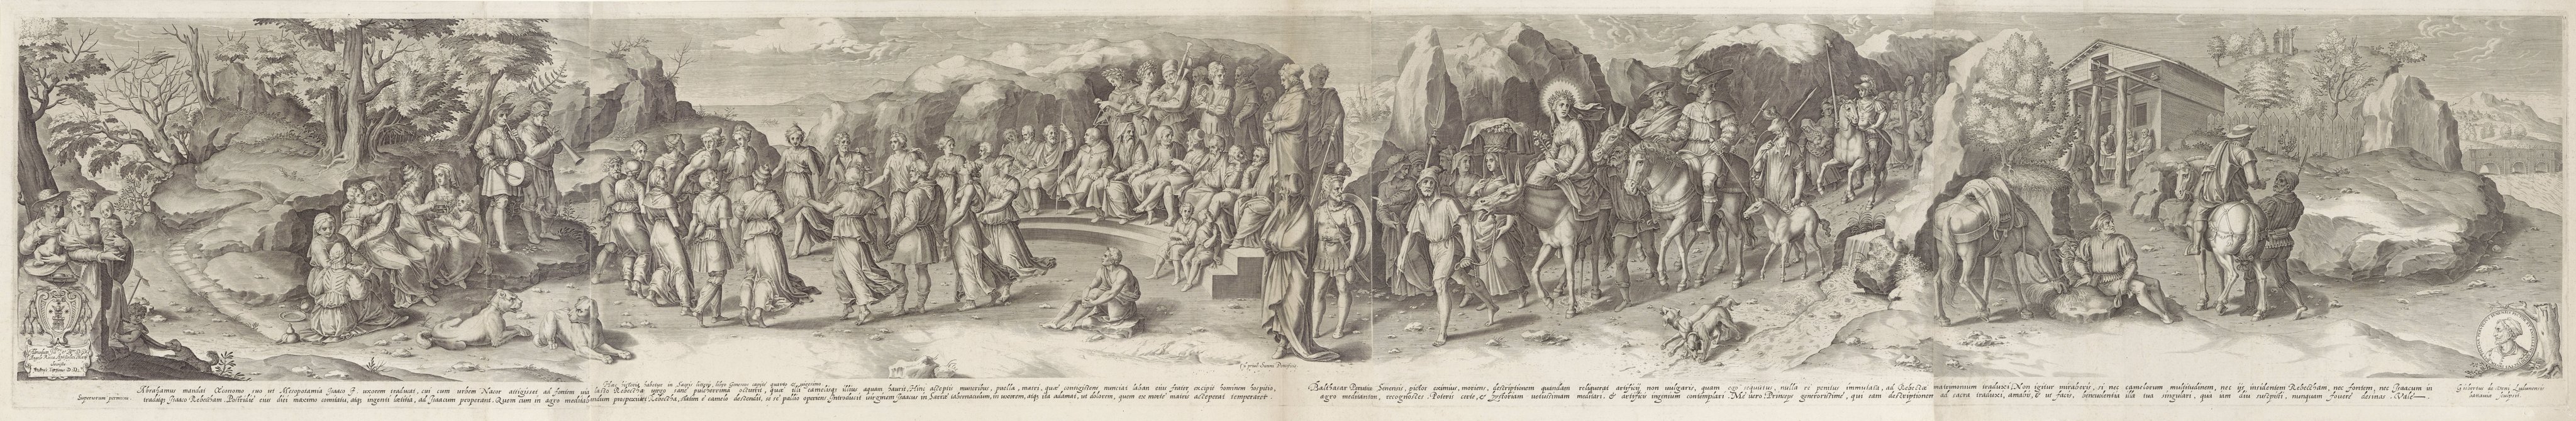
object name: print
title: Huwelijk van Isaak en Rebekka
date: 1599-1645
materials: paper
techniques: engraving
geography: rome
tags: marriage of isaac and rebekah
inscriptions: collector's mark: Lugt 2228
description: Dit object is omwille van een betere presentatie virtueel samengevoegd, maar bestaat fysiek uit losse onderdelen.